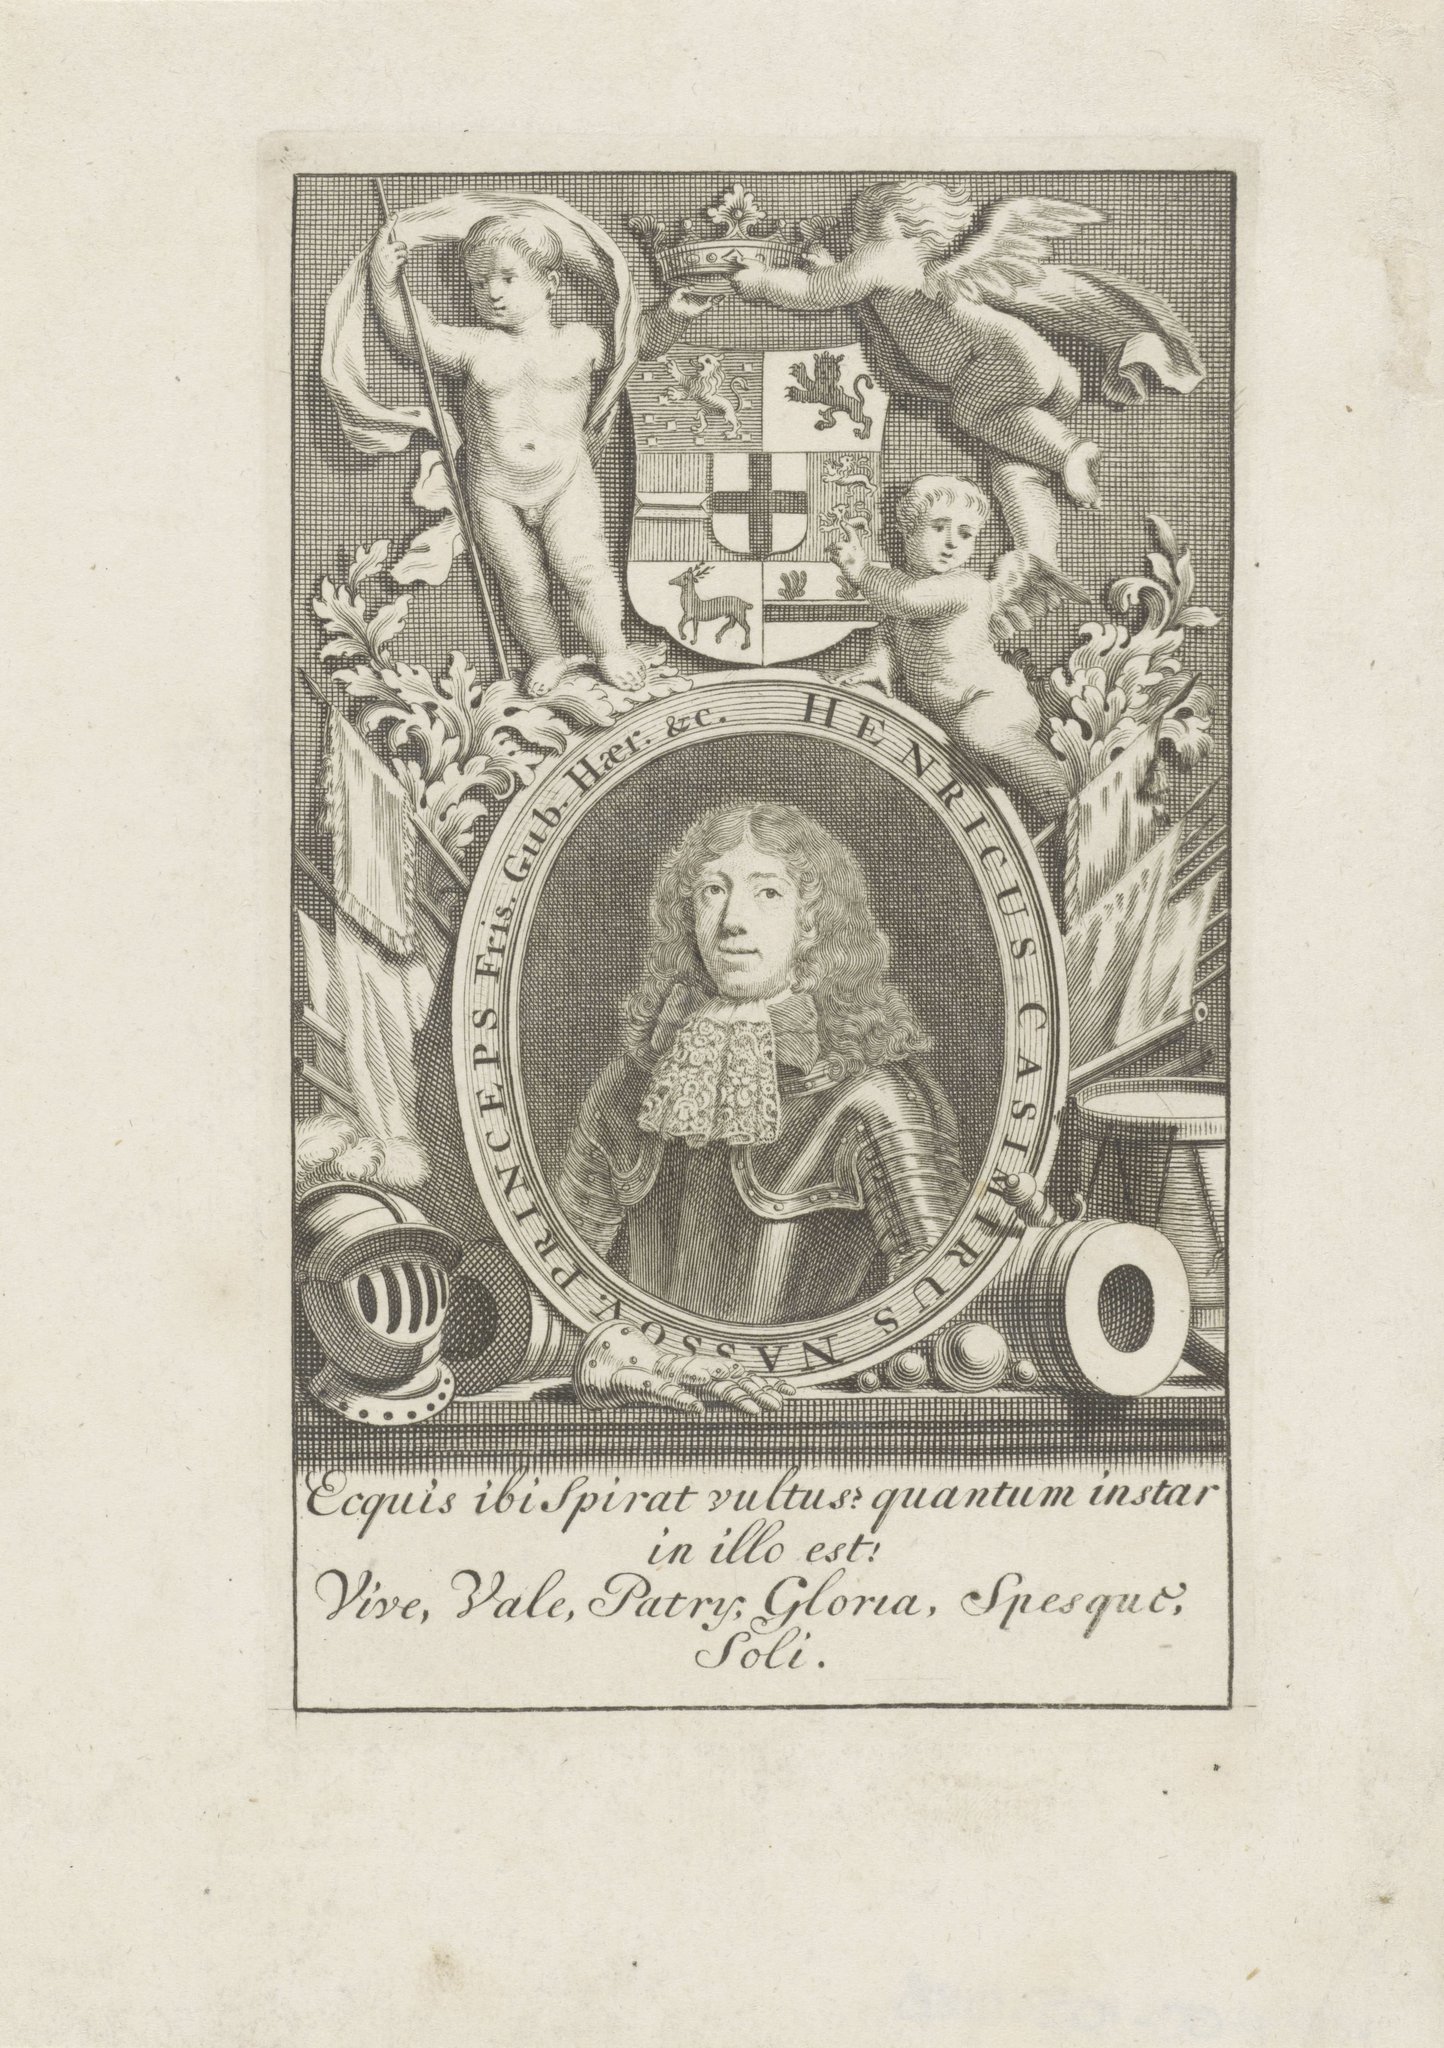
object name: print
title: Portret van Hendrik Casimir II, graaf van Nassau-Dietz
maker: Anonymous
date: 1675-1749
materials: paper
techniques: engraving, etching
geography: low countries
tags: the hague, hendrik casimir ii graaf van nassau-dietz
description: Portret van Hendrik Casimir II in een ovaal met randschrift. Midden boven zijn wapen. Daar omheen een aantal allegorische objecten en figuren. In een kader vier regels Latijnse tekst.